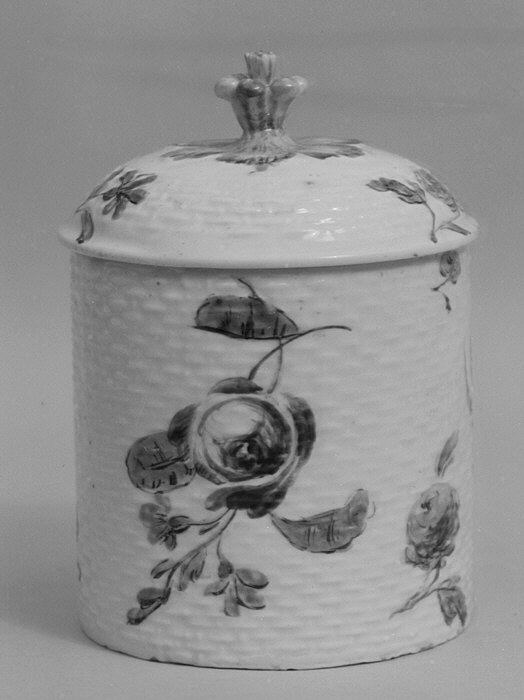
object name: toilet jar with cover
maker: mennecy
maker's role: factory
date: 1765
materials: soft paste porcelain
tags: flowers